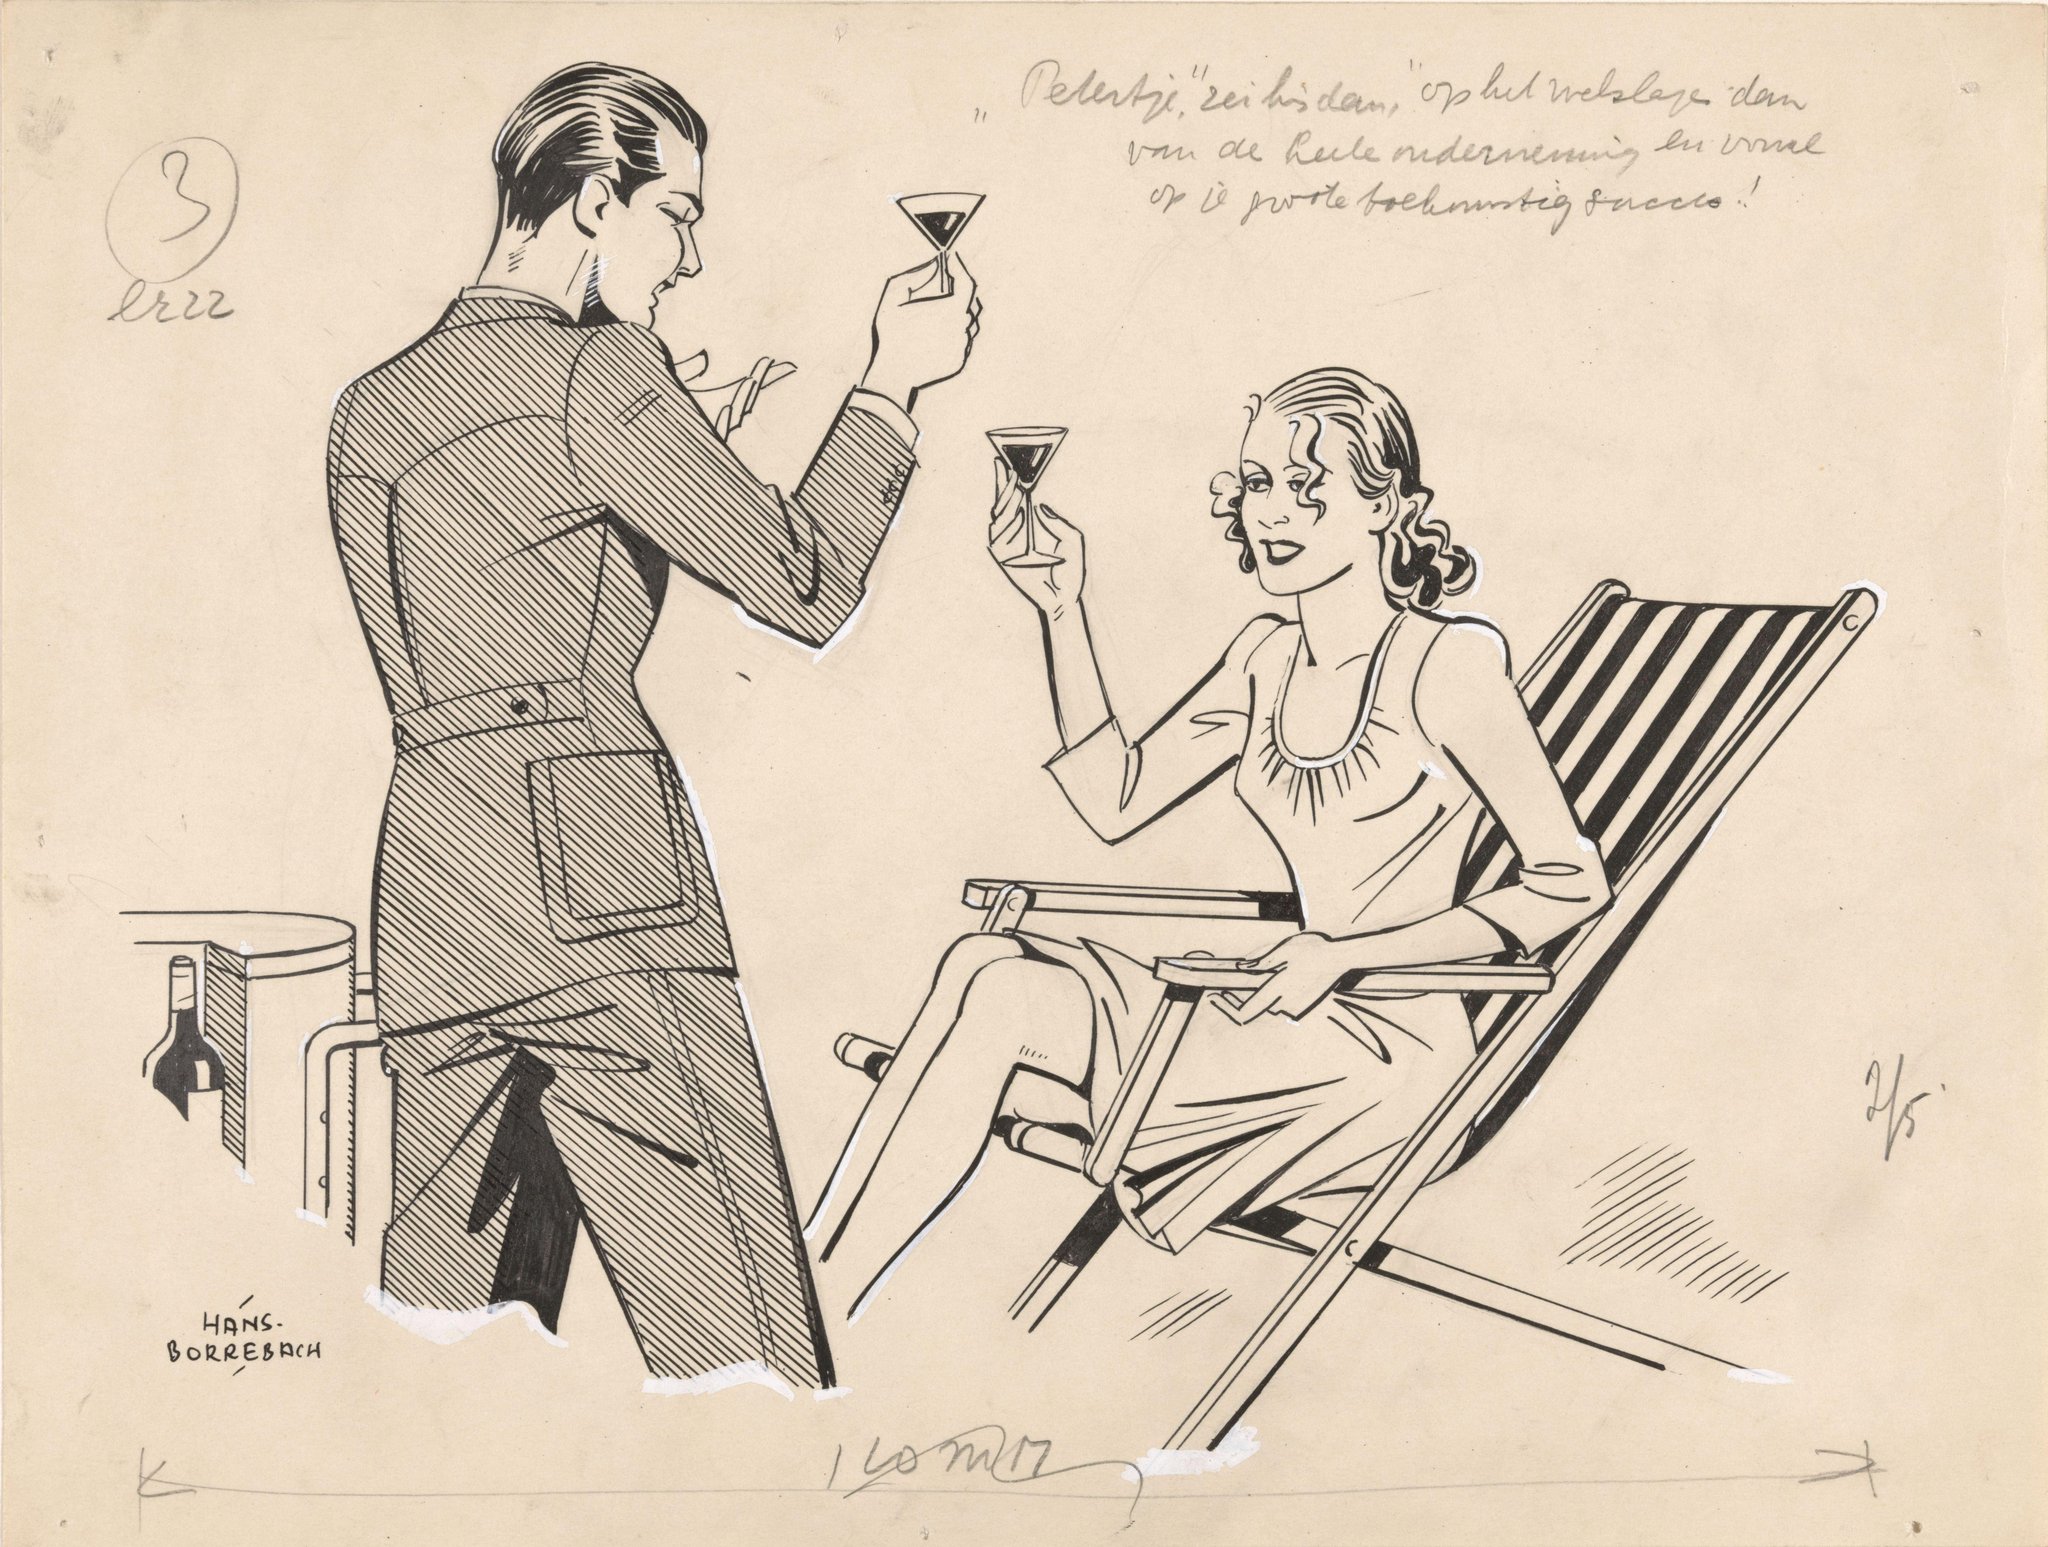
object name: boekillustratie ontwerp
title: Man brengt een toost uit op Pepita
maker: hans borrebach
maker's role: draughtsman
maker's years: 1903-1991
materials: paint, ink, paper, pencil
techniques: brush, pen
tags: alcoholic drinks, chair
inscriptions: :, collector's mark: Lugt 2228a, signature: ‘HANS./ BORREBACH’, annotation: ‘3/ blz 22/ "Petertje", zei hij dan, "op het welslagen dan/ van de heele onderneming en vooral/ op je groote toekomstige succes!’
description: Ontwerp voor: Borrebach, Hans. Een hart klopt voor Pepita. Roman voor oudere meisjes. Amsterdam: Veen, 1948.